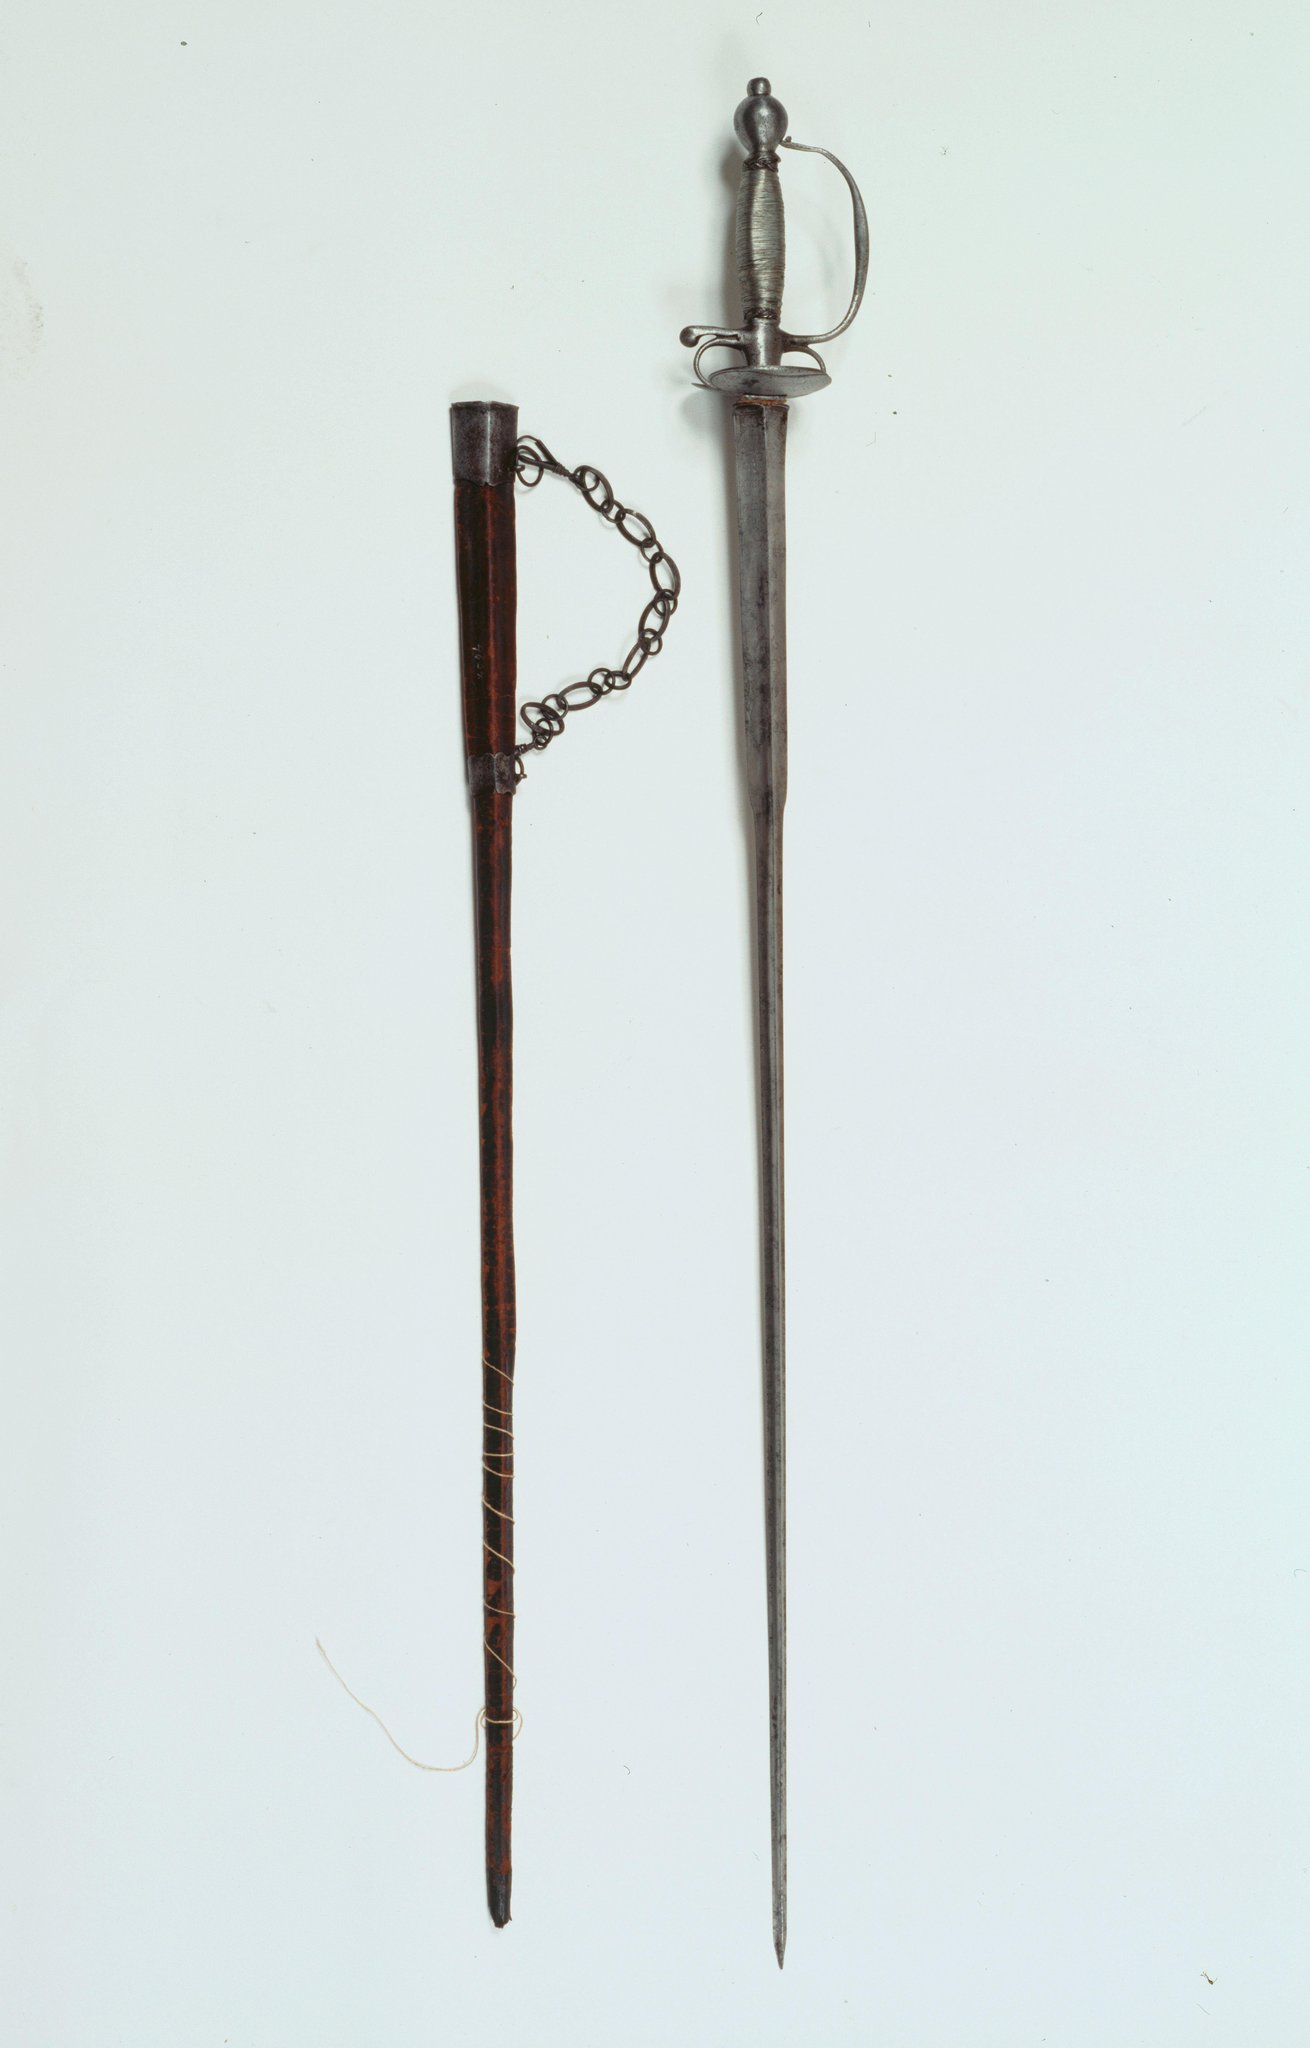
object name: sword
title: Degen met ijzeren gevest met omwoelde greep en leren schede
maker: Anonymous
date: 1675-1700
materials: iron, leather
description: IJzeren degen. Gevest met knop en omwikkelde greep. Halve pareerstang, ezelshoef en stootplaten. Driekantige kling, zich versmallend, met op een zijde geëtst opschrift: Fran van Demmeltraedt Zwaardveger te Nimegen. Op de andere zijde: Francois van Demmeltraed Fourbisseur a Nimegen. Het geheel in geëtste ornamenten. Met lederen schede met ketting, draagbanden.